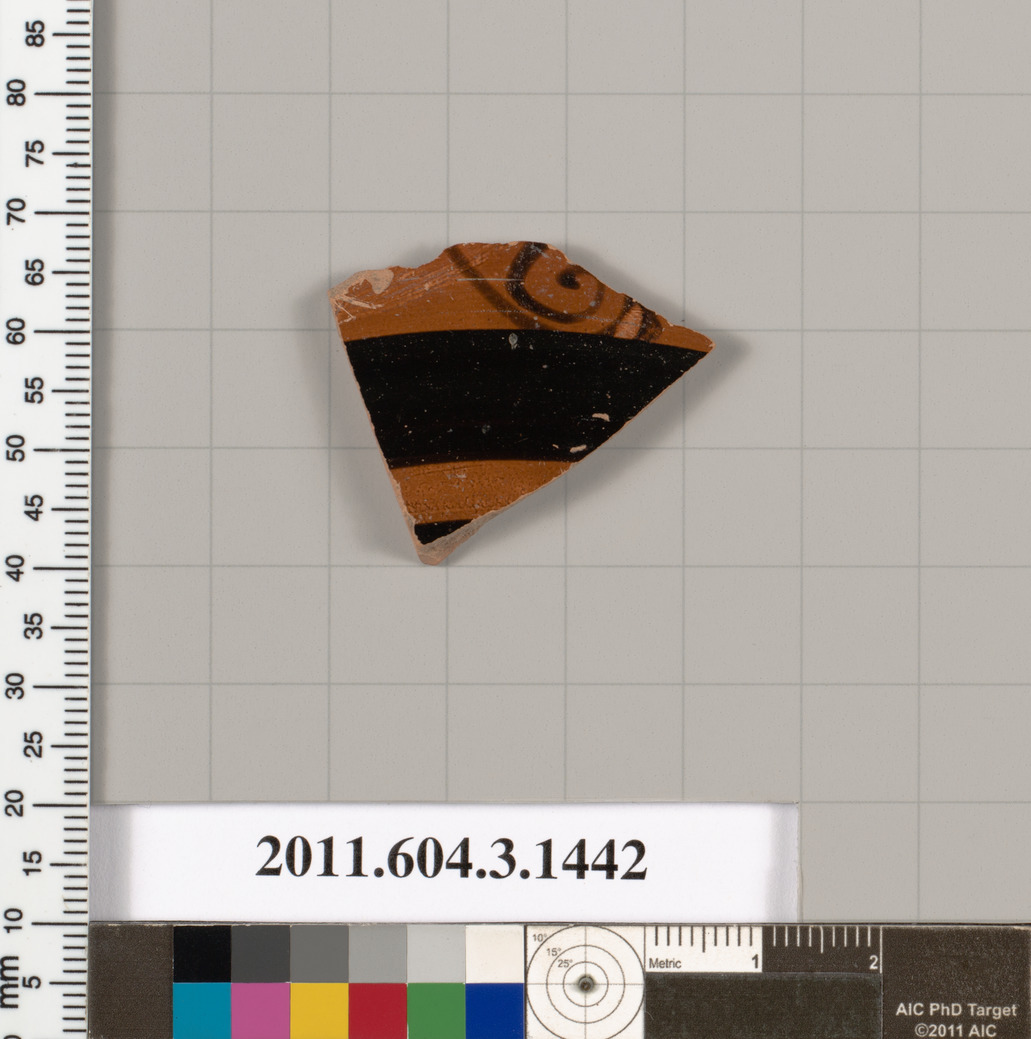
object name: skyphos fragment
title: Terracotta fragment of a skyphos (deep drinking cup)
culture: greek, attic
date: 534-468 BCE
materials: terracotta